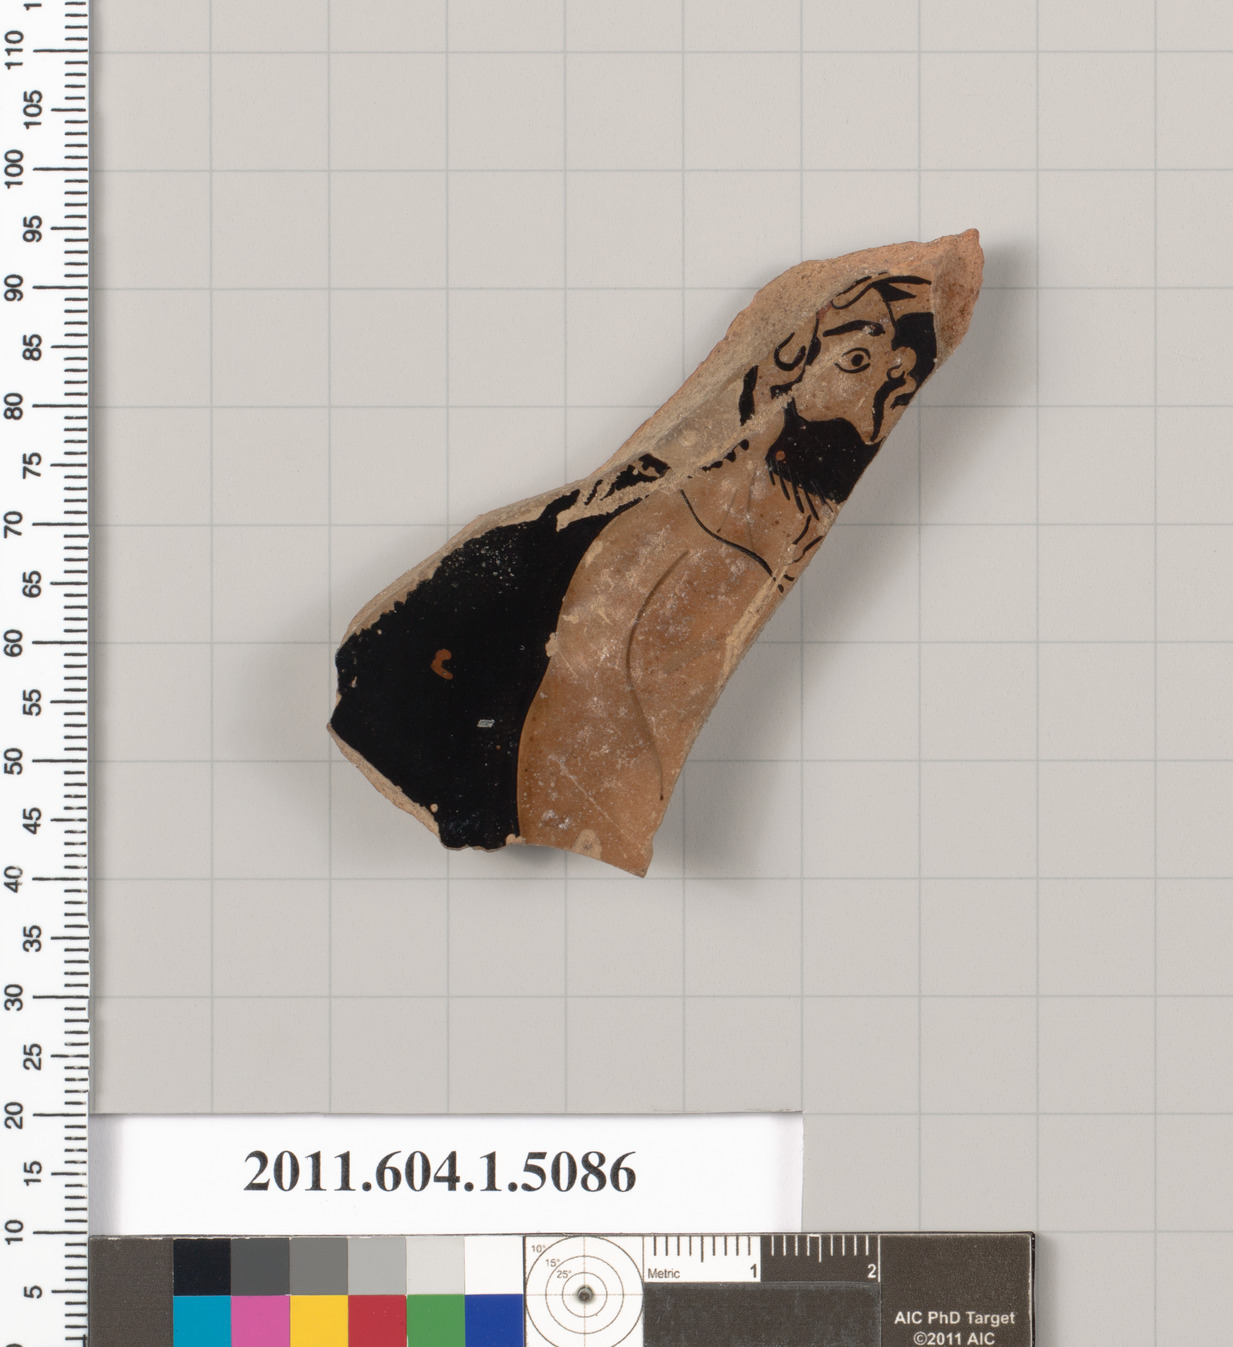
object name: kylix fragment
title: Terracotta fragment of a kylix (drinking cup)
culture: greek, attic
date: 510-500 BCE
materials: terracotta